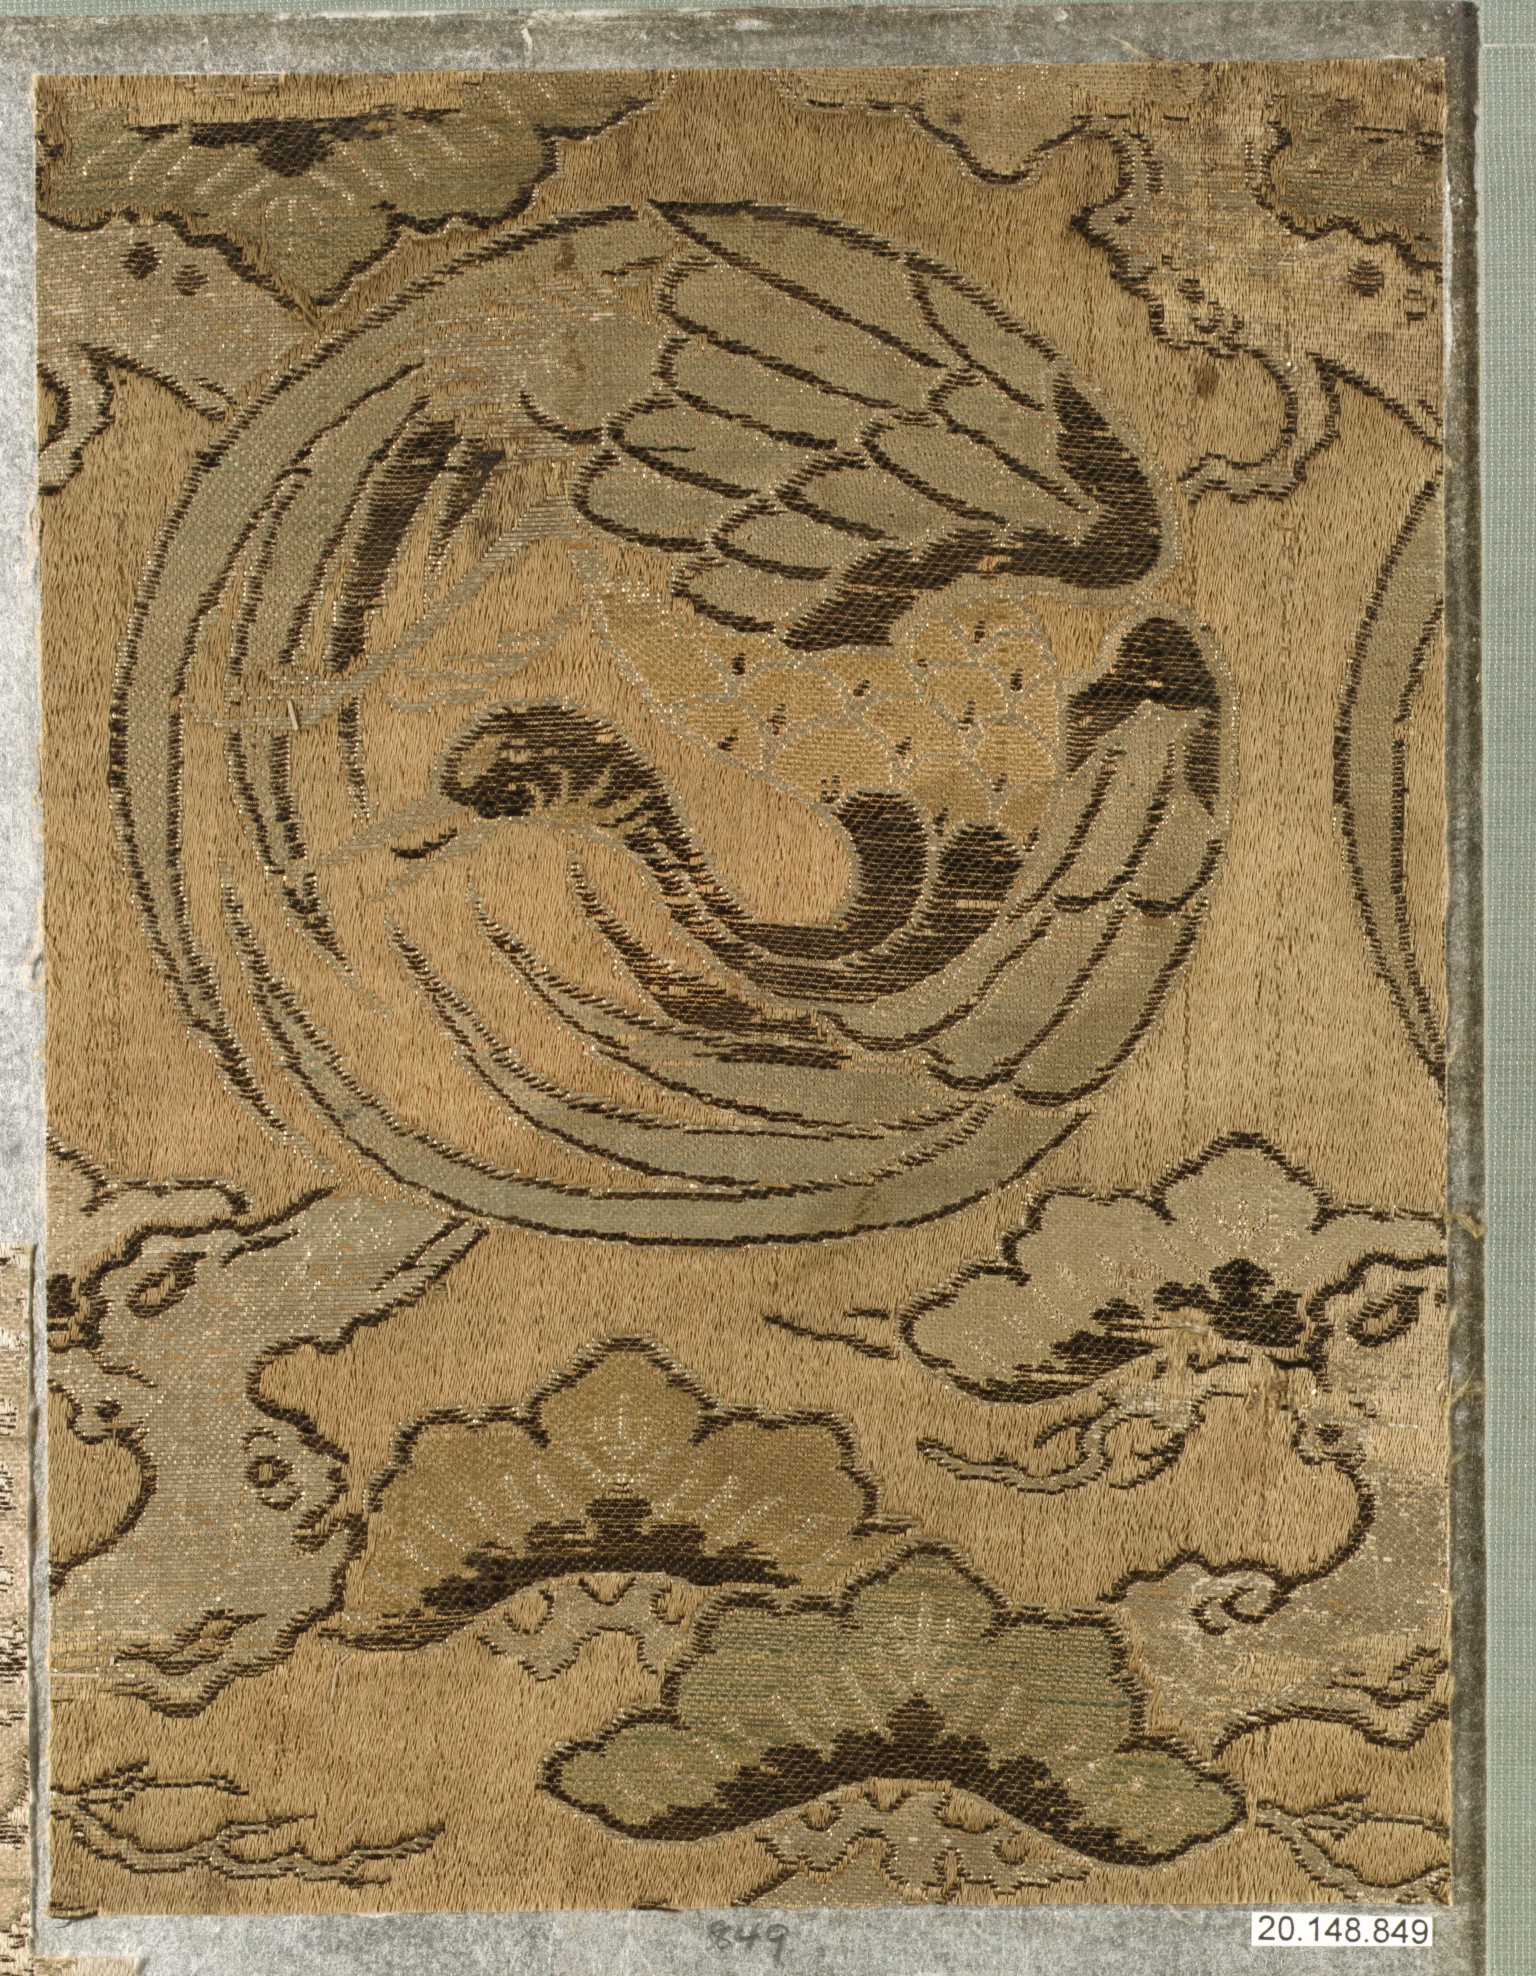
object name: piece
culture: japanese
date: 1701-1800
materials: silk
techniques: compound weave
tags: birds